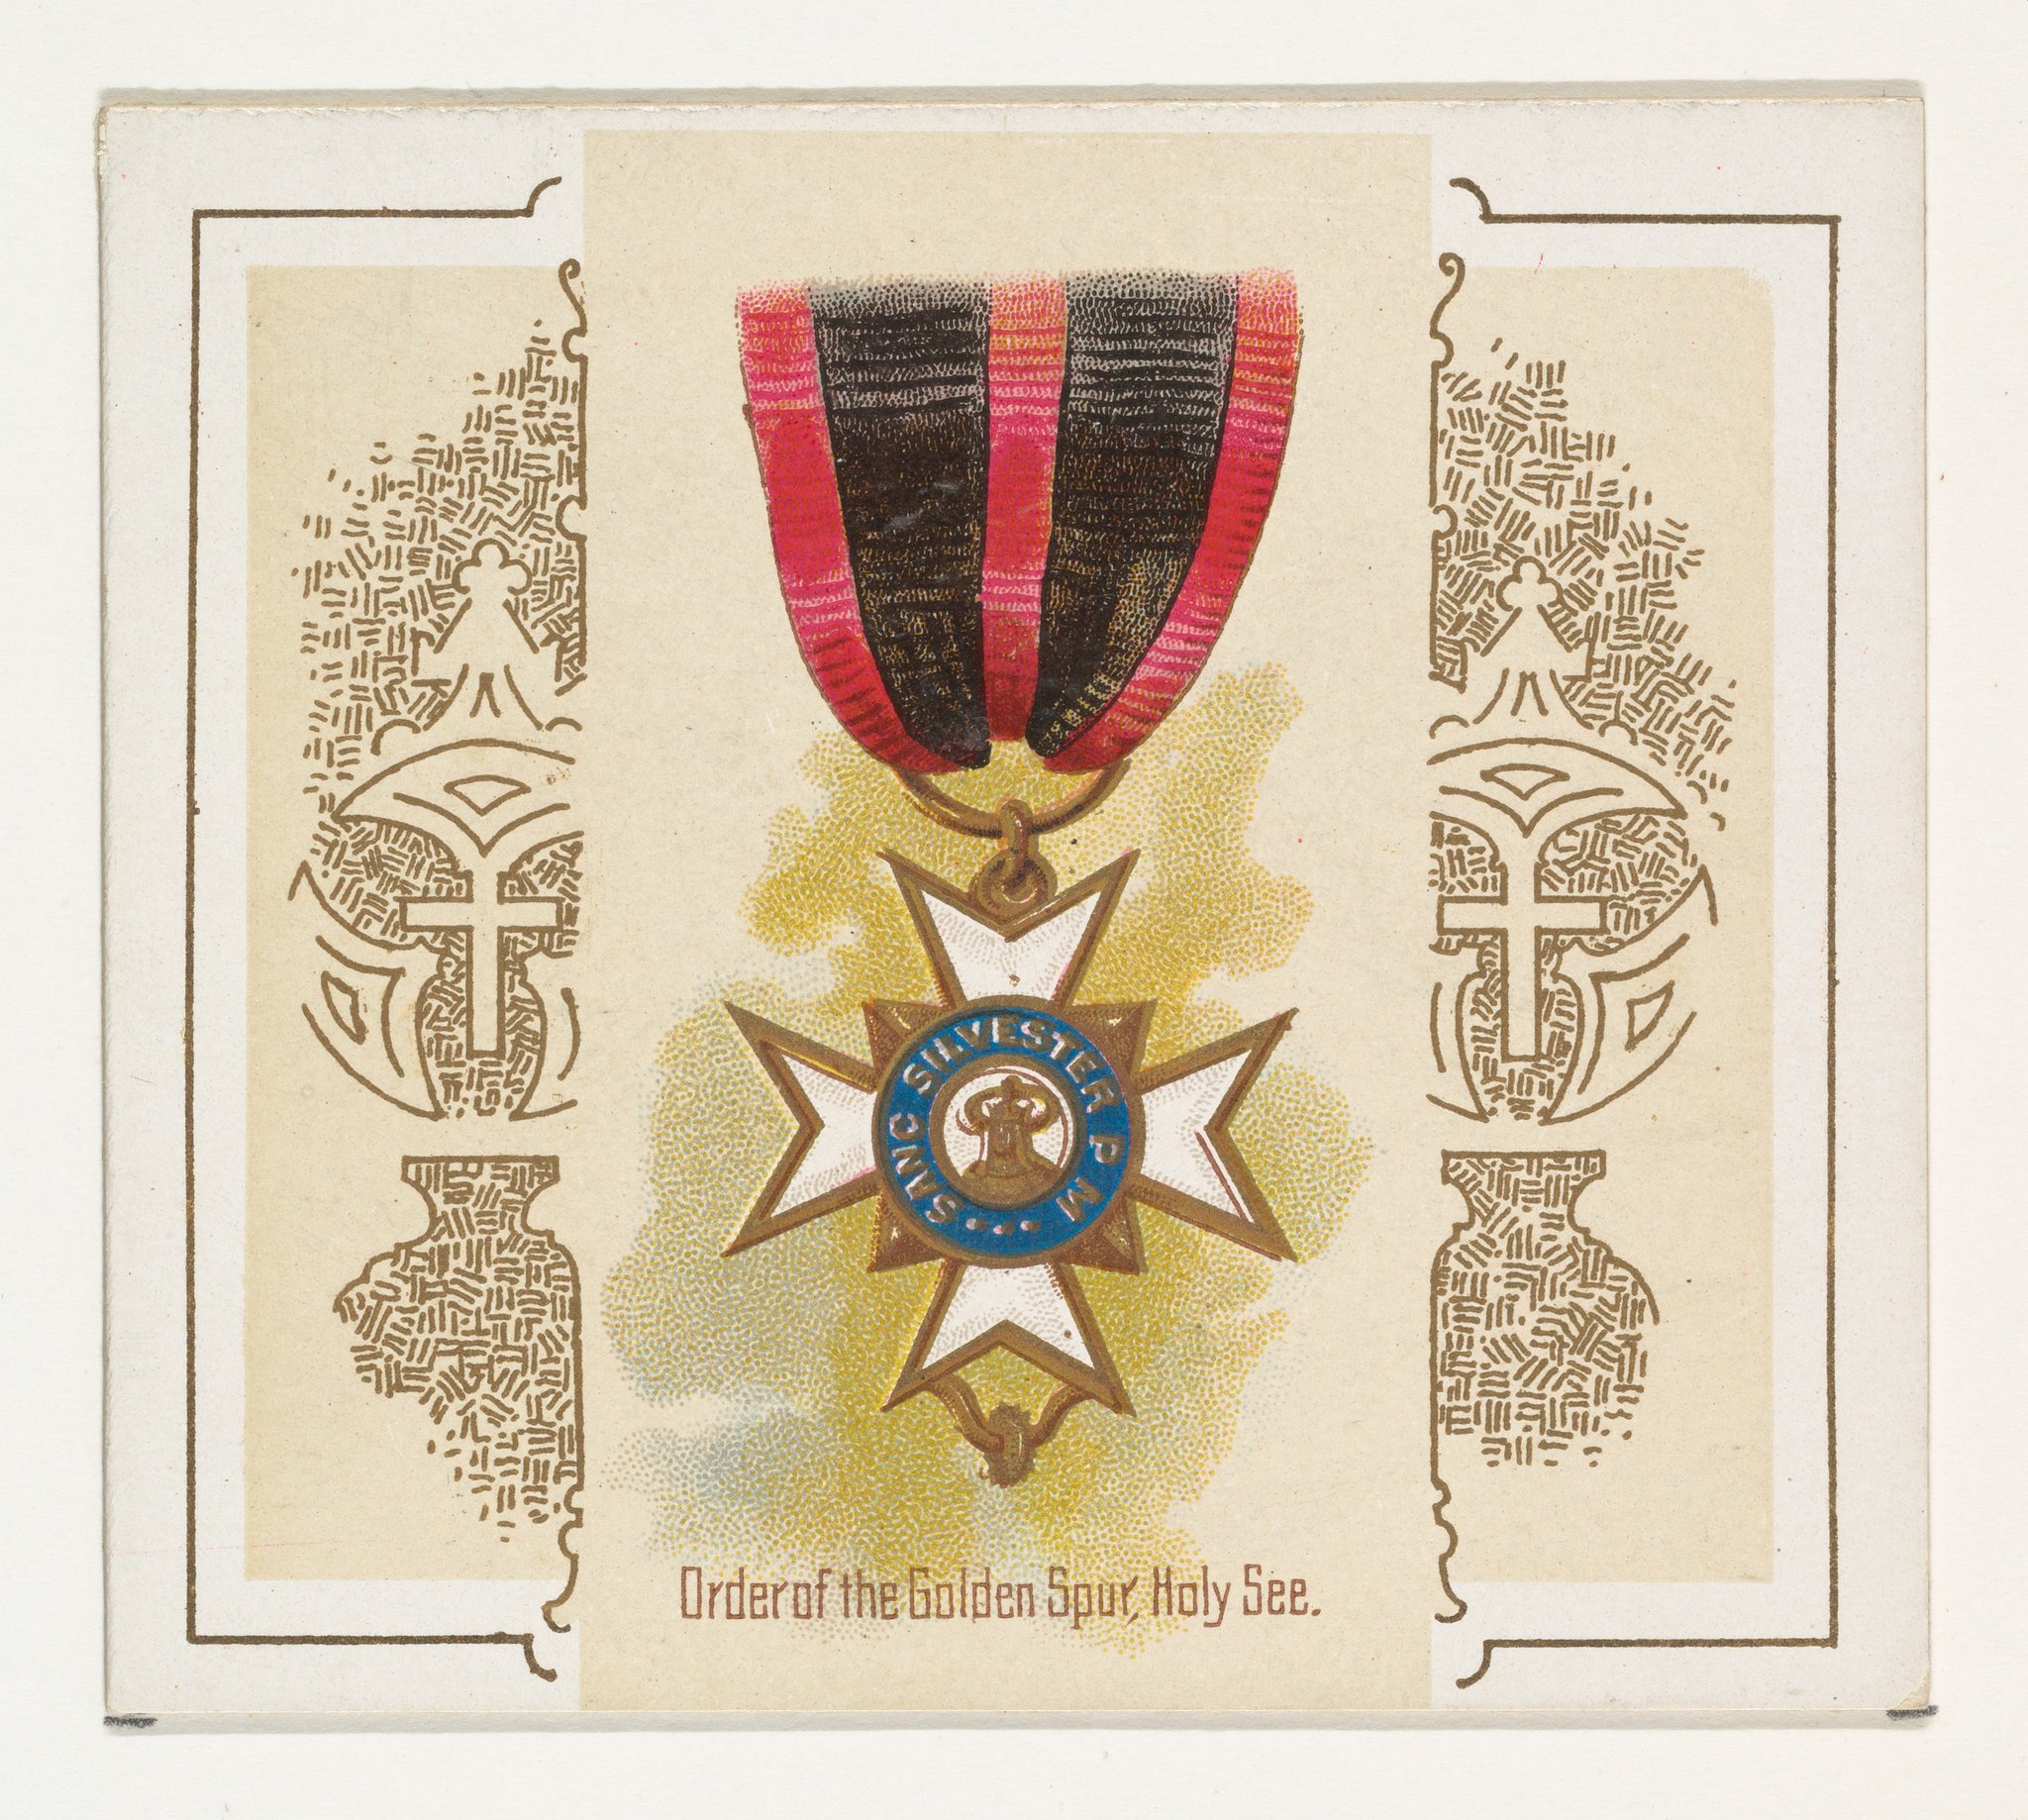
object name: print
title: Order of the Golden Spur, Holy See, from the World's Decorations series (N44) for Allen & Ginter Cigarettes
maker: allen & ginter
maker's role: publisher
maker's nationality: american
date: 1890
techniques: color lithograph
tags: medals